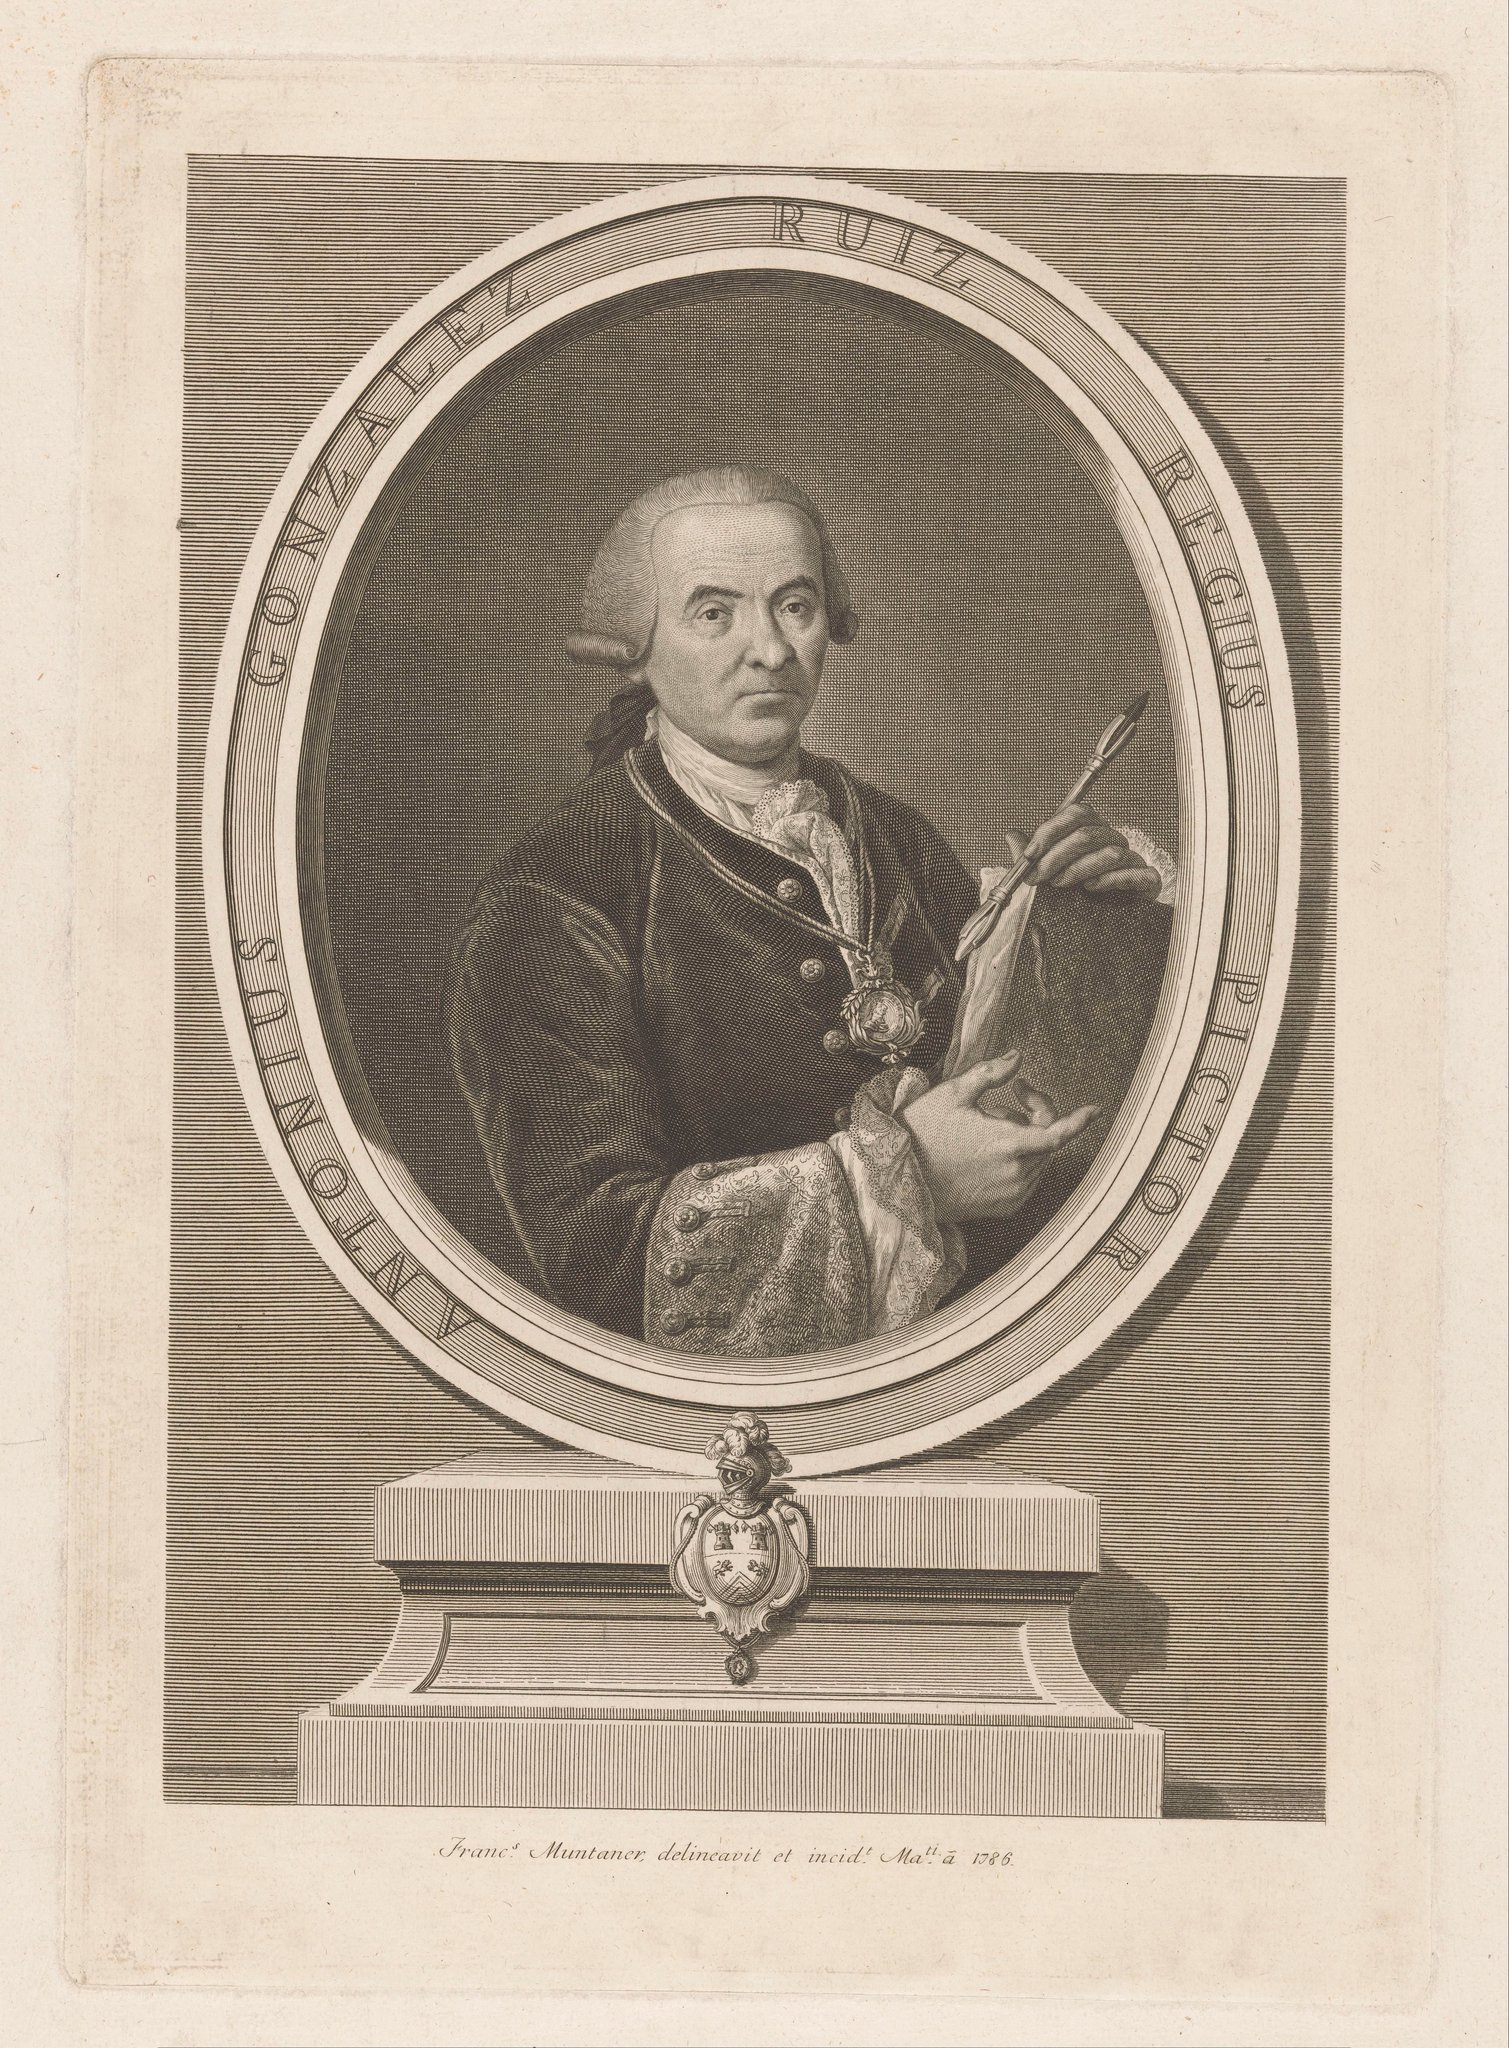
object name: print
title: Portret van Antonio González Ruiz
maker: francisco muntaner moner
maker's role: painter, print maker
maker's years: 1743-1805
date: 1786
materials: paper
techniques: engraving, etching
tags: painter, historical persons, portrait, self-portrait of painter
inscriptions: collector's mark: Lugt 2482, collector's mark: Lugt 1606, collector's mark: Lugt 2228